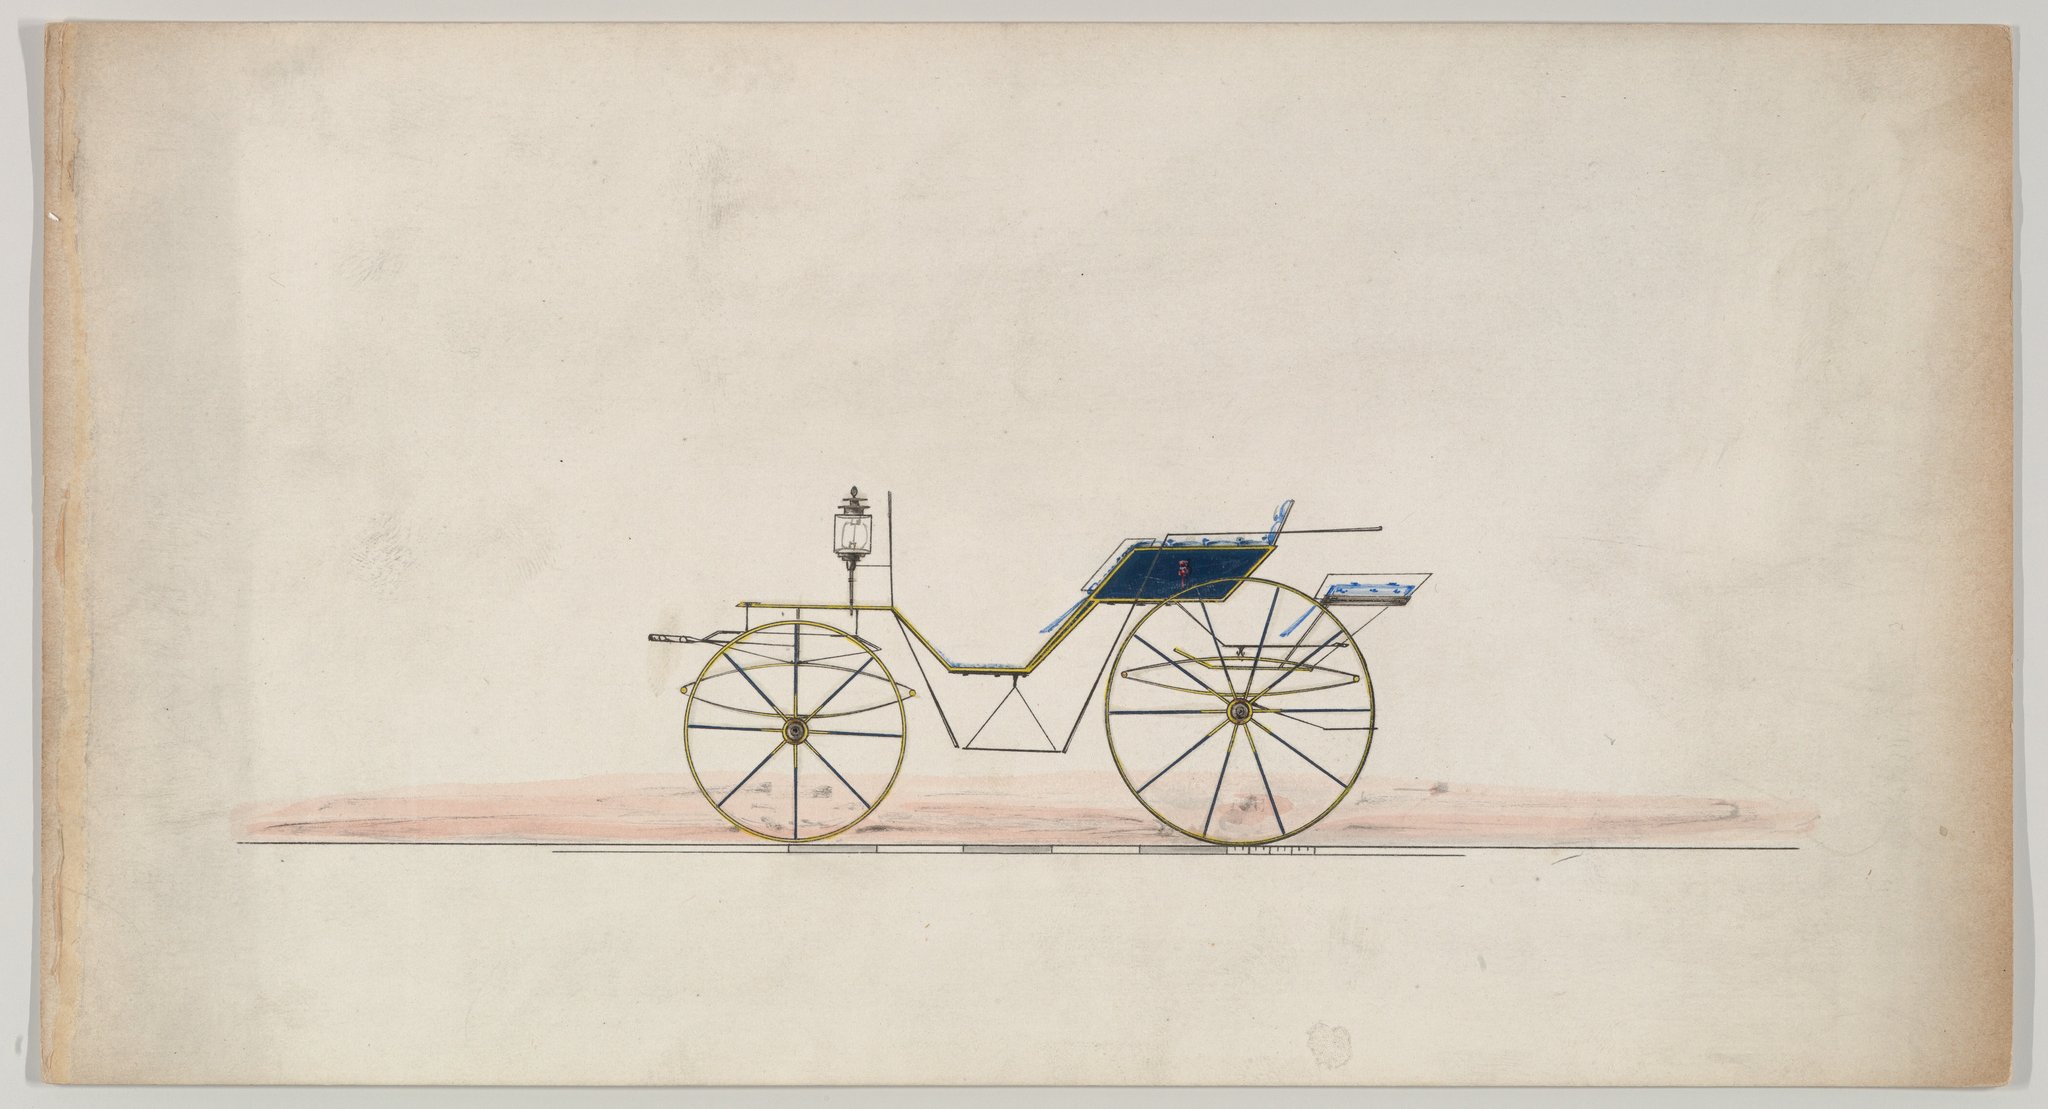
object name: drawing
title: Drop Front Phaeton (unnumbered)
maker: brewster & co.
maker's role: manufacturer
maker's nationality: american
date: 1870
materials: gouache, gum arabic, ink, watercolor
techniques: pen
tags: carriages